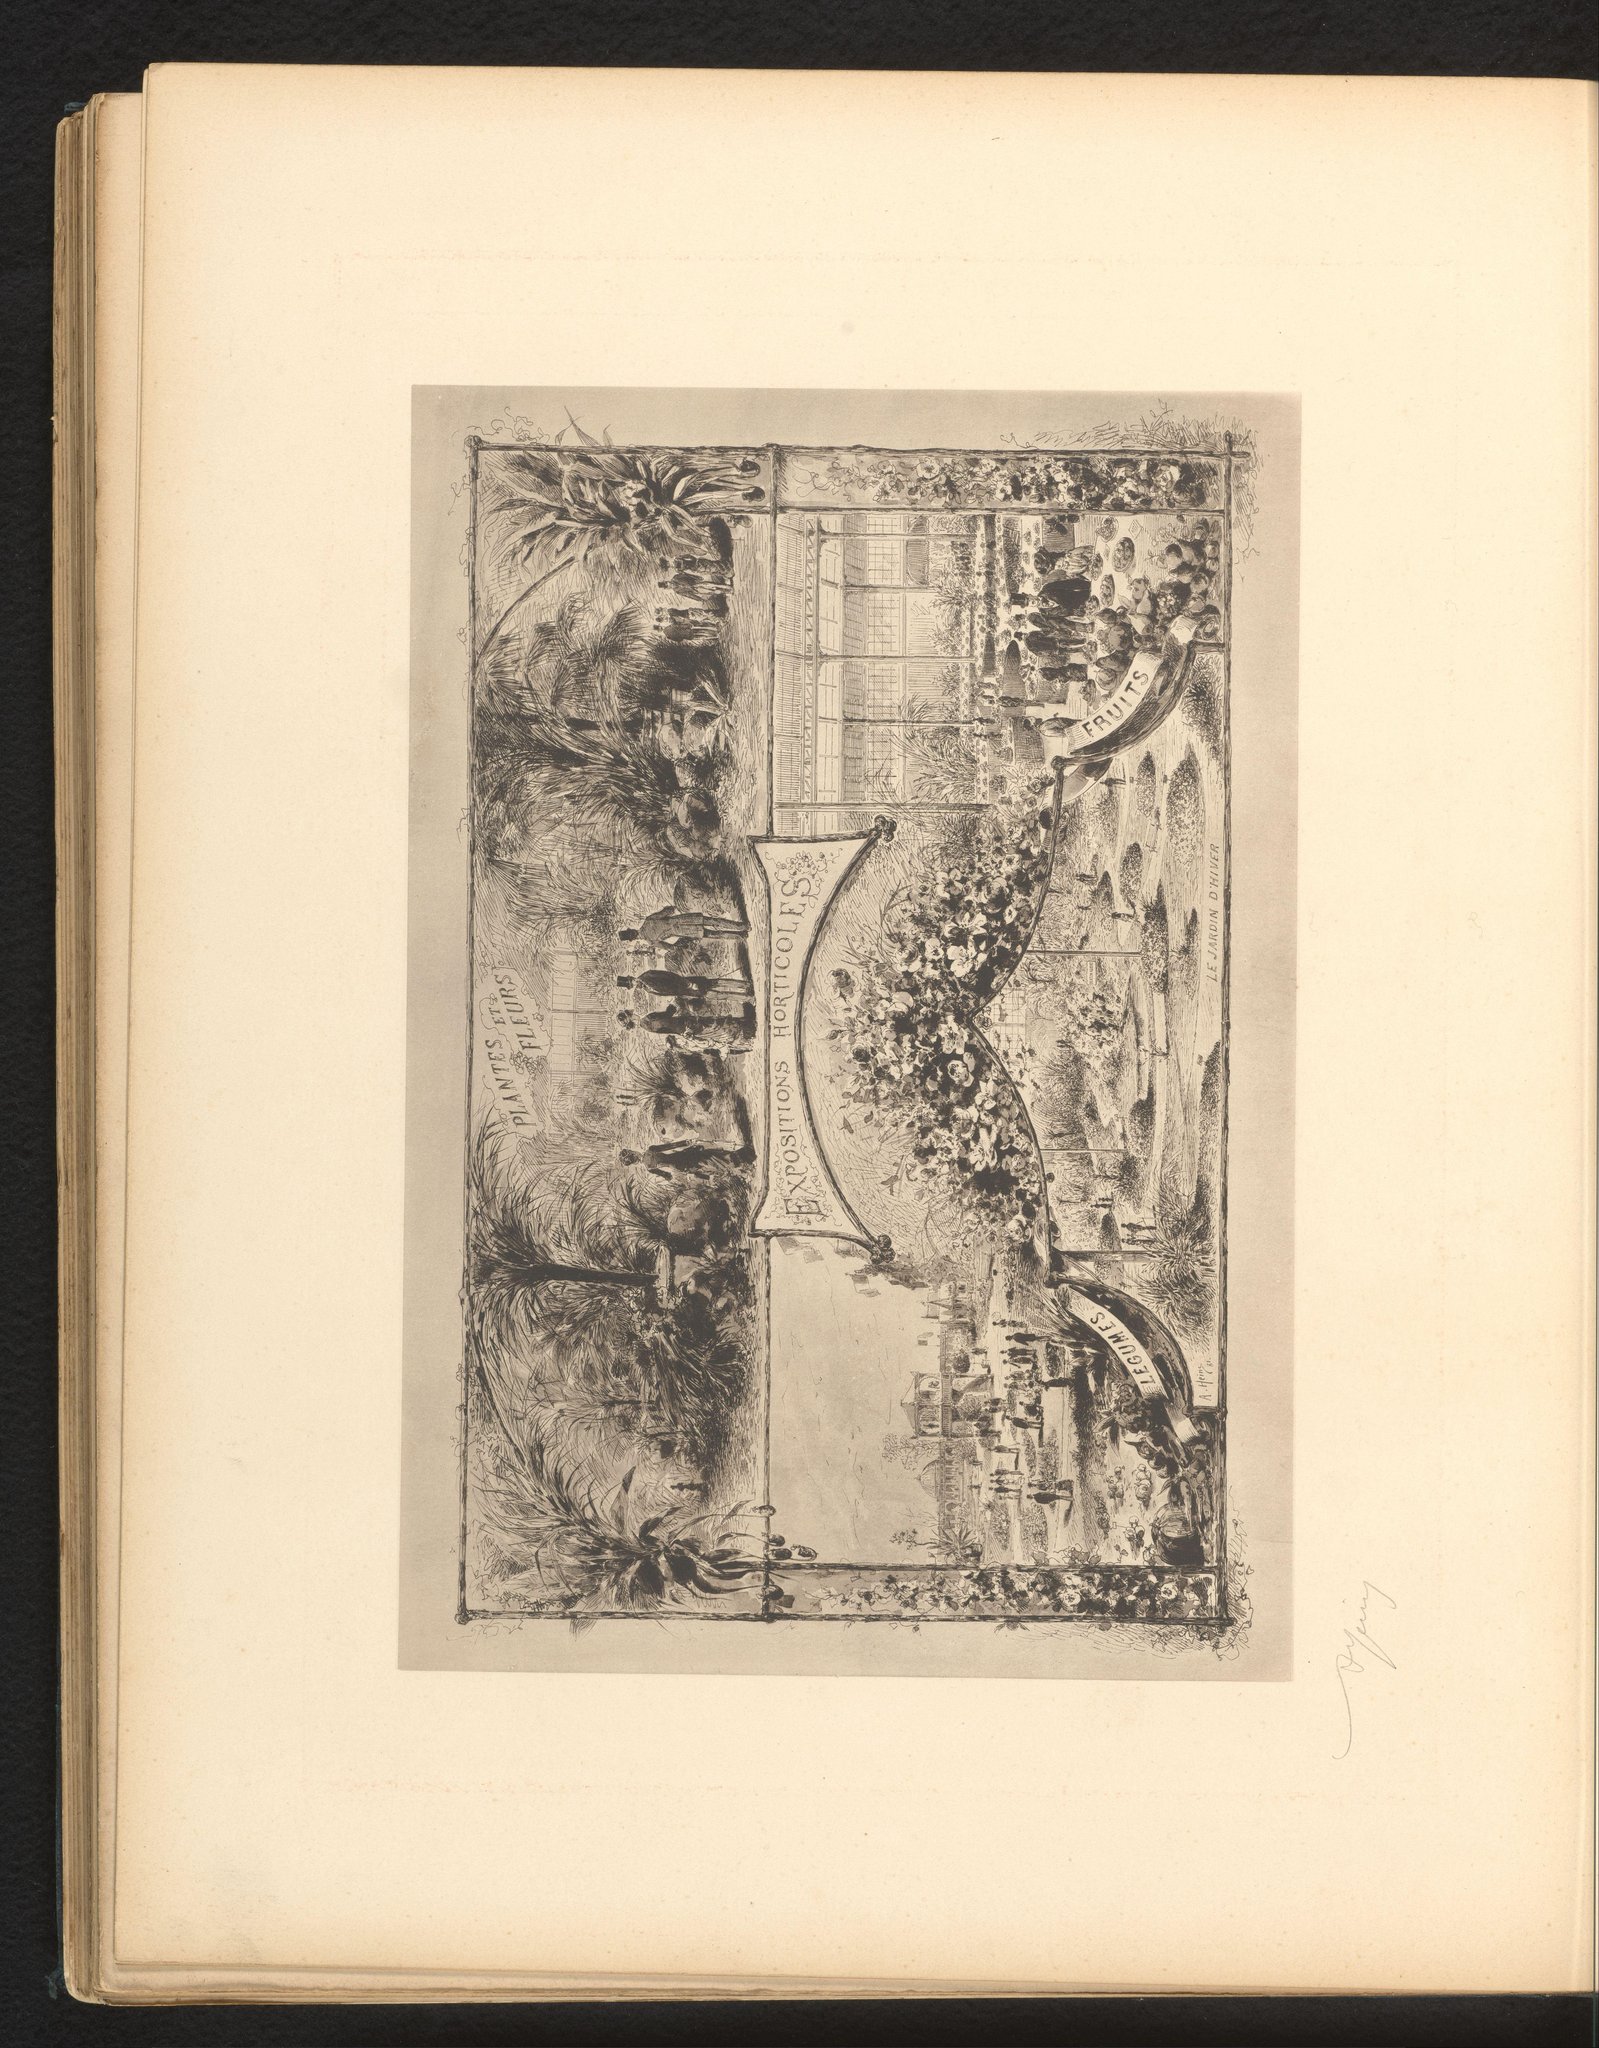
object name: photomechanical print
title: Reproductie van een gravure van een botanische tuin op de Exposition Nationale van 1880 in Brussel, door Armand Heins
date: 1881-1882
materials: paper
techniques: photograph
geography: brussels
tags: trade exhibition, industries fair, botanic garden, 'hortus botanicus', brussels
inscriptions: name: ‘Heins’